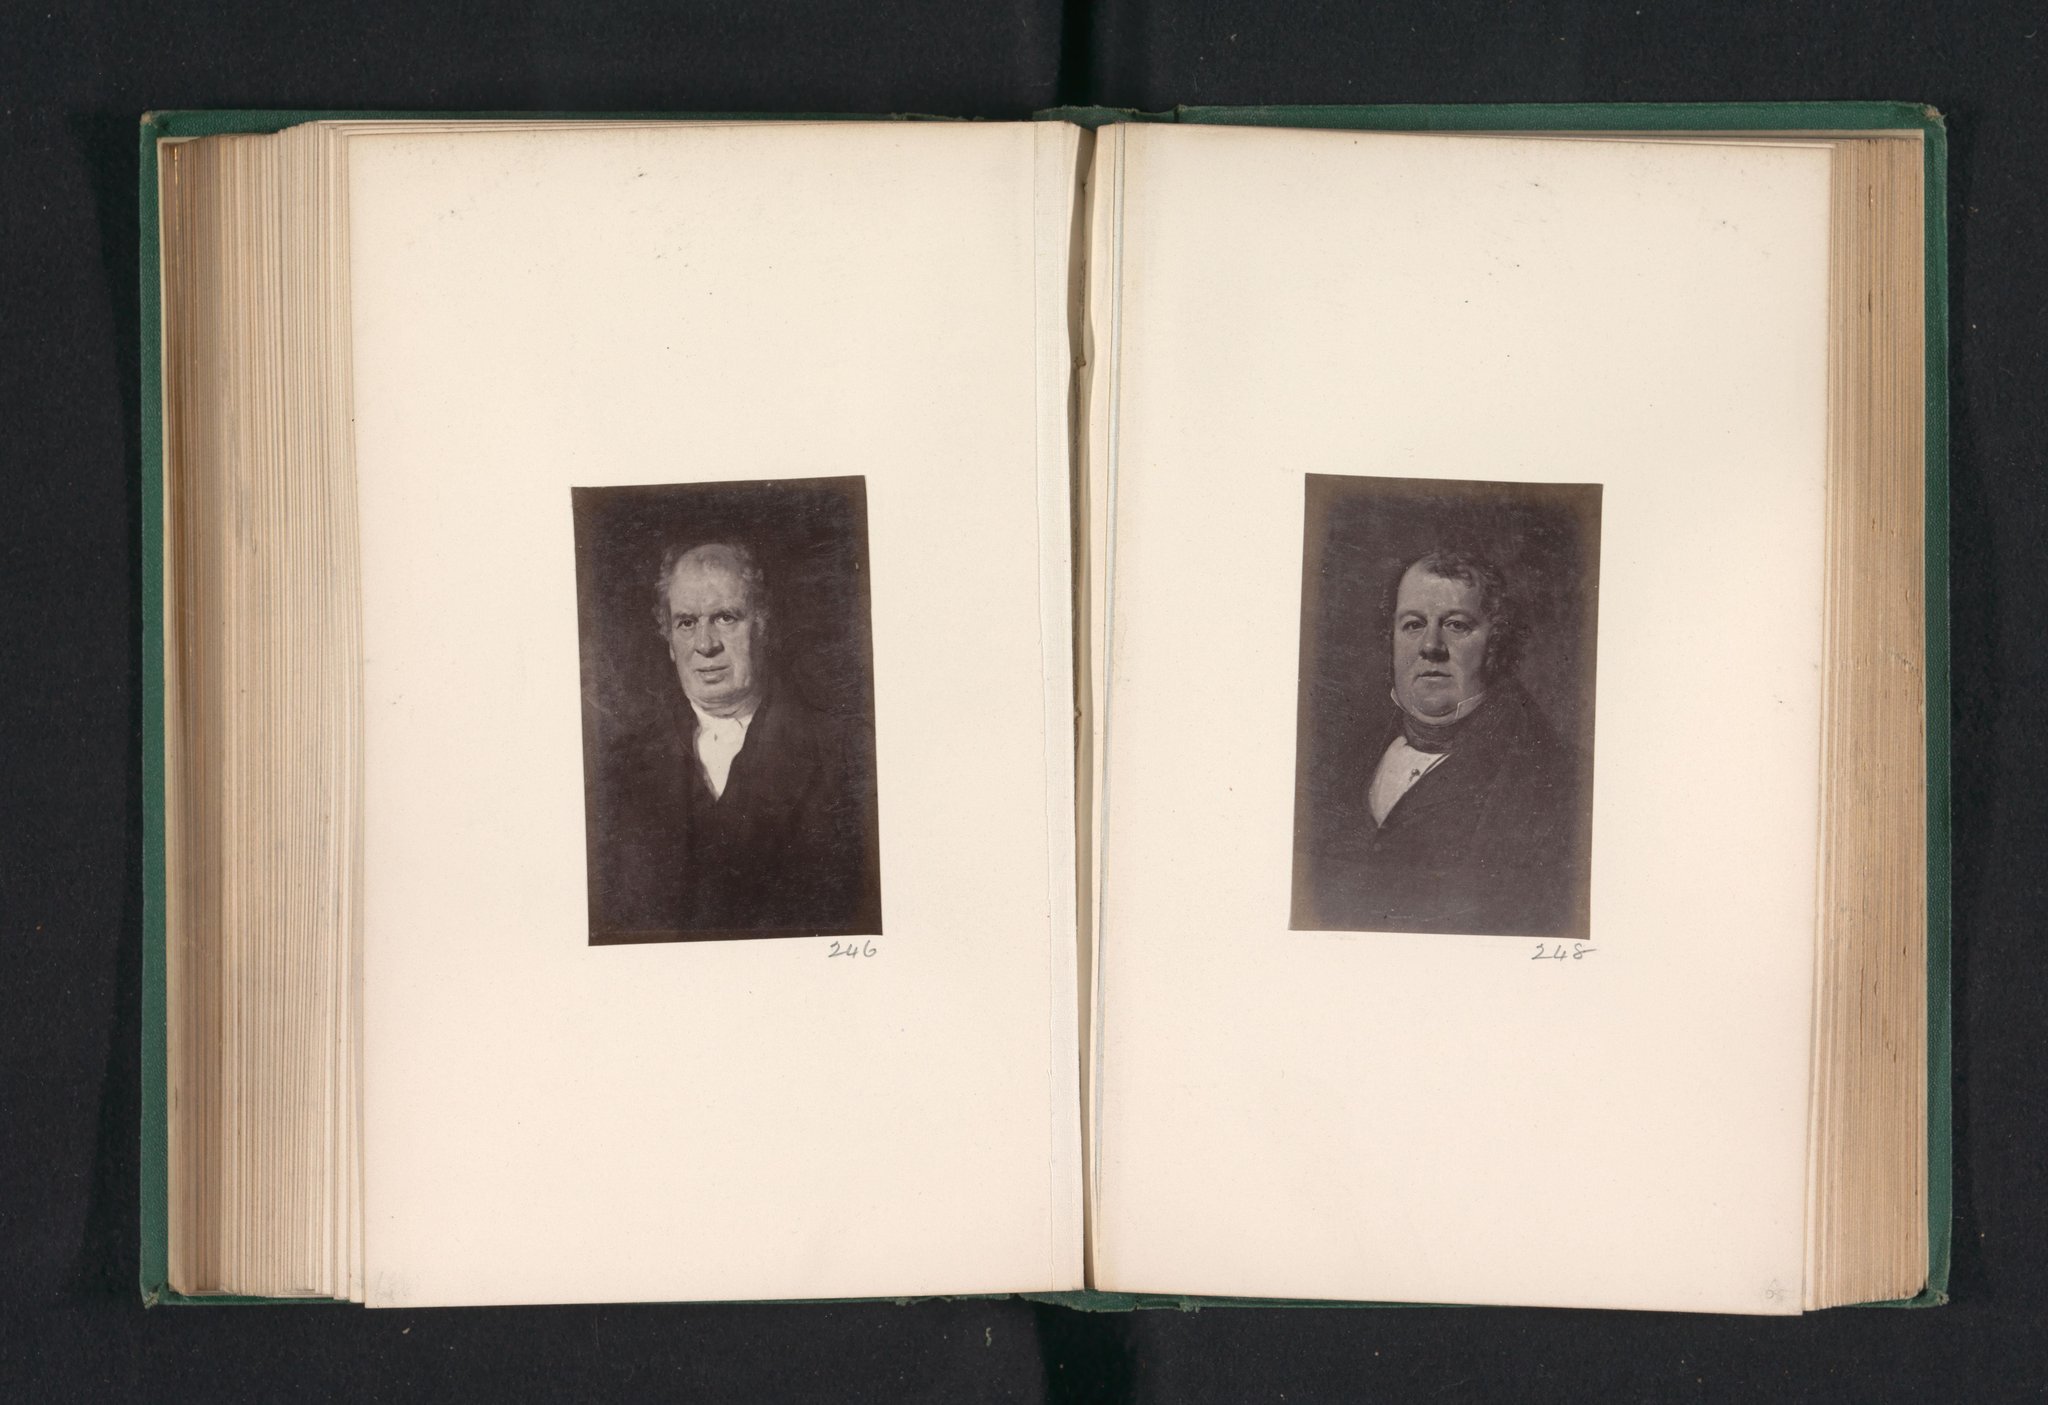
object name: page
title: Fotoreproductie van een schilderij, voorstellende een portret van Andrew Stephenson Dalglish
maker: thomas annan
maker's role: fotograaf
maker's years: 1829-1887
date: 1863-1868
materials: photographic support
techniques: albumen print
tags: historical persons (portraits and scenes from the life) (+ (full) bust portrait)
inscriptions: number: ‘248’